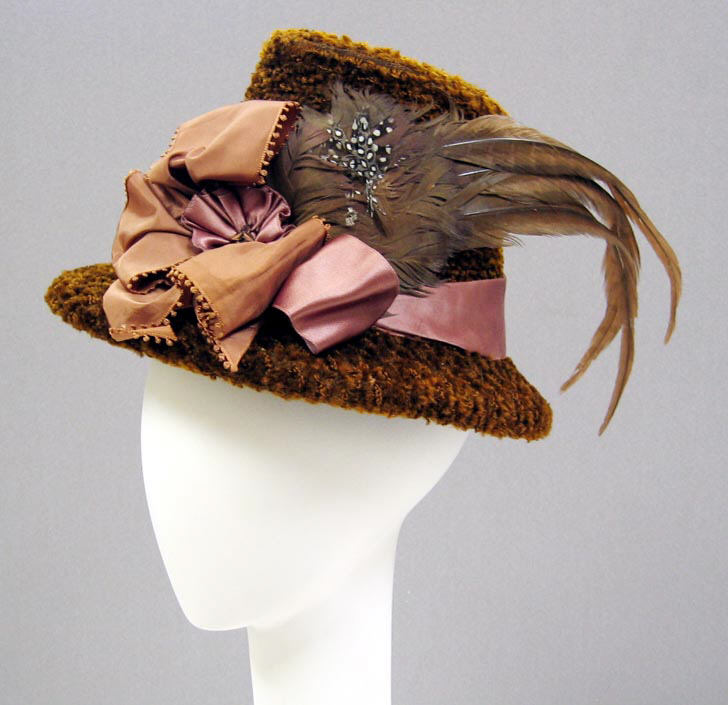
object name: hat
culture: american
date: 1870-1879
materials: cotton, feather, silk